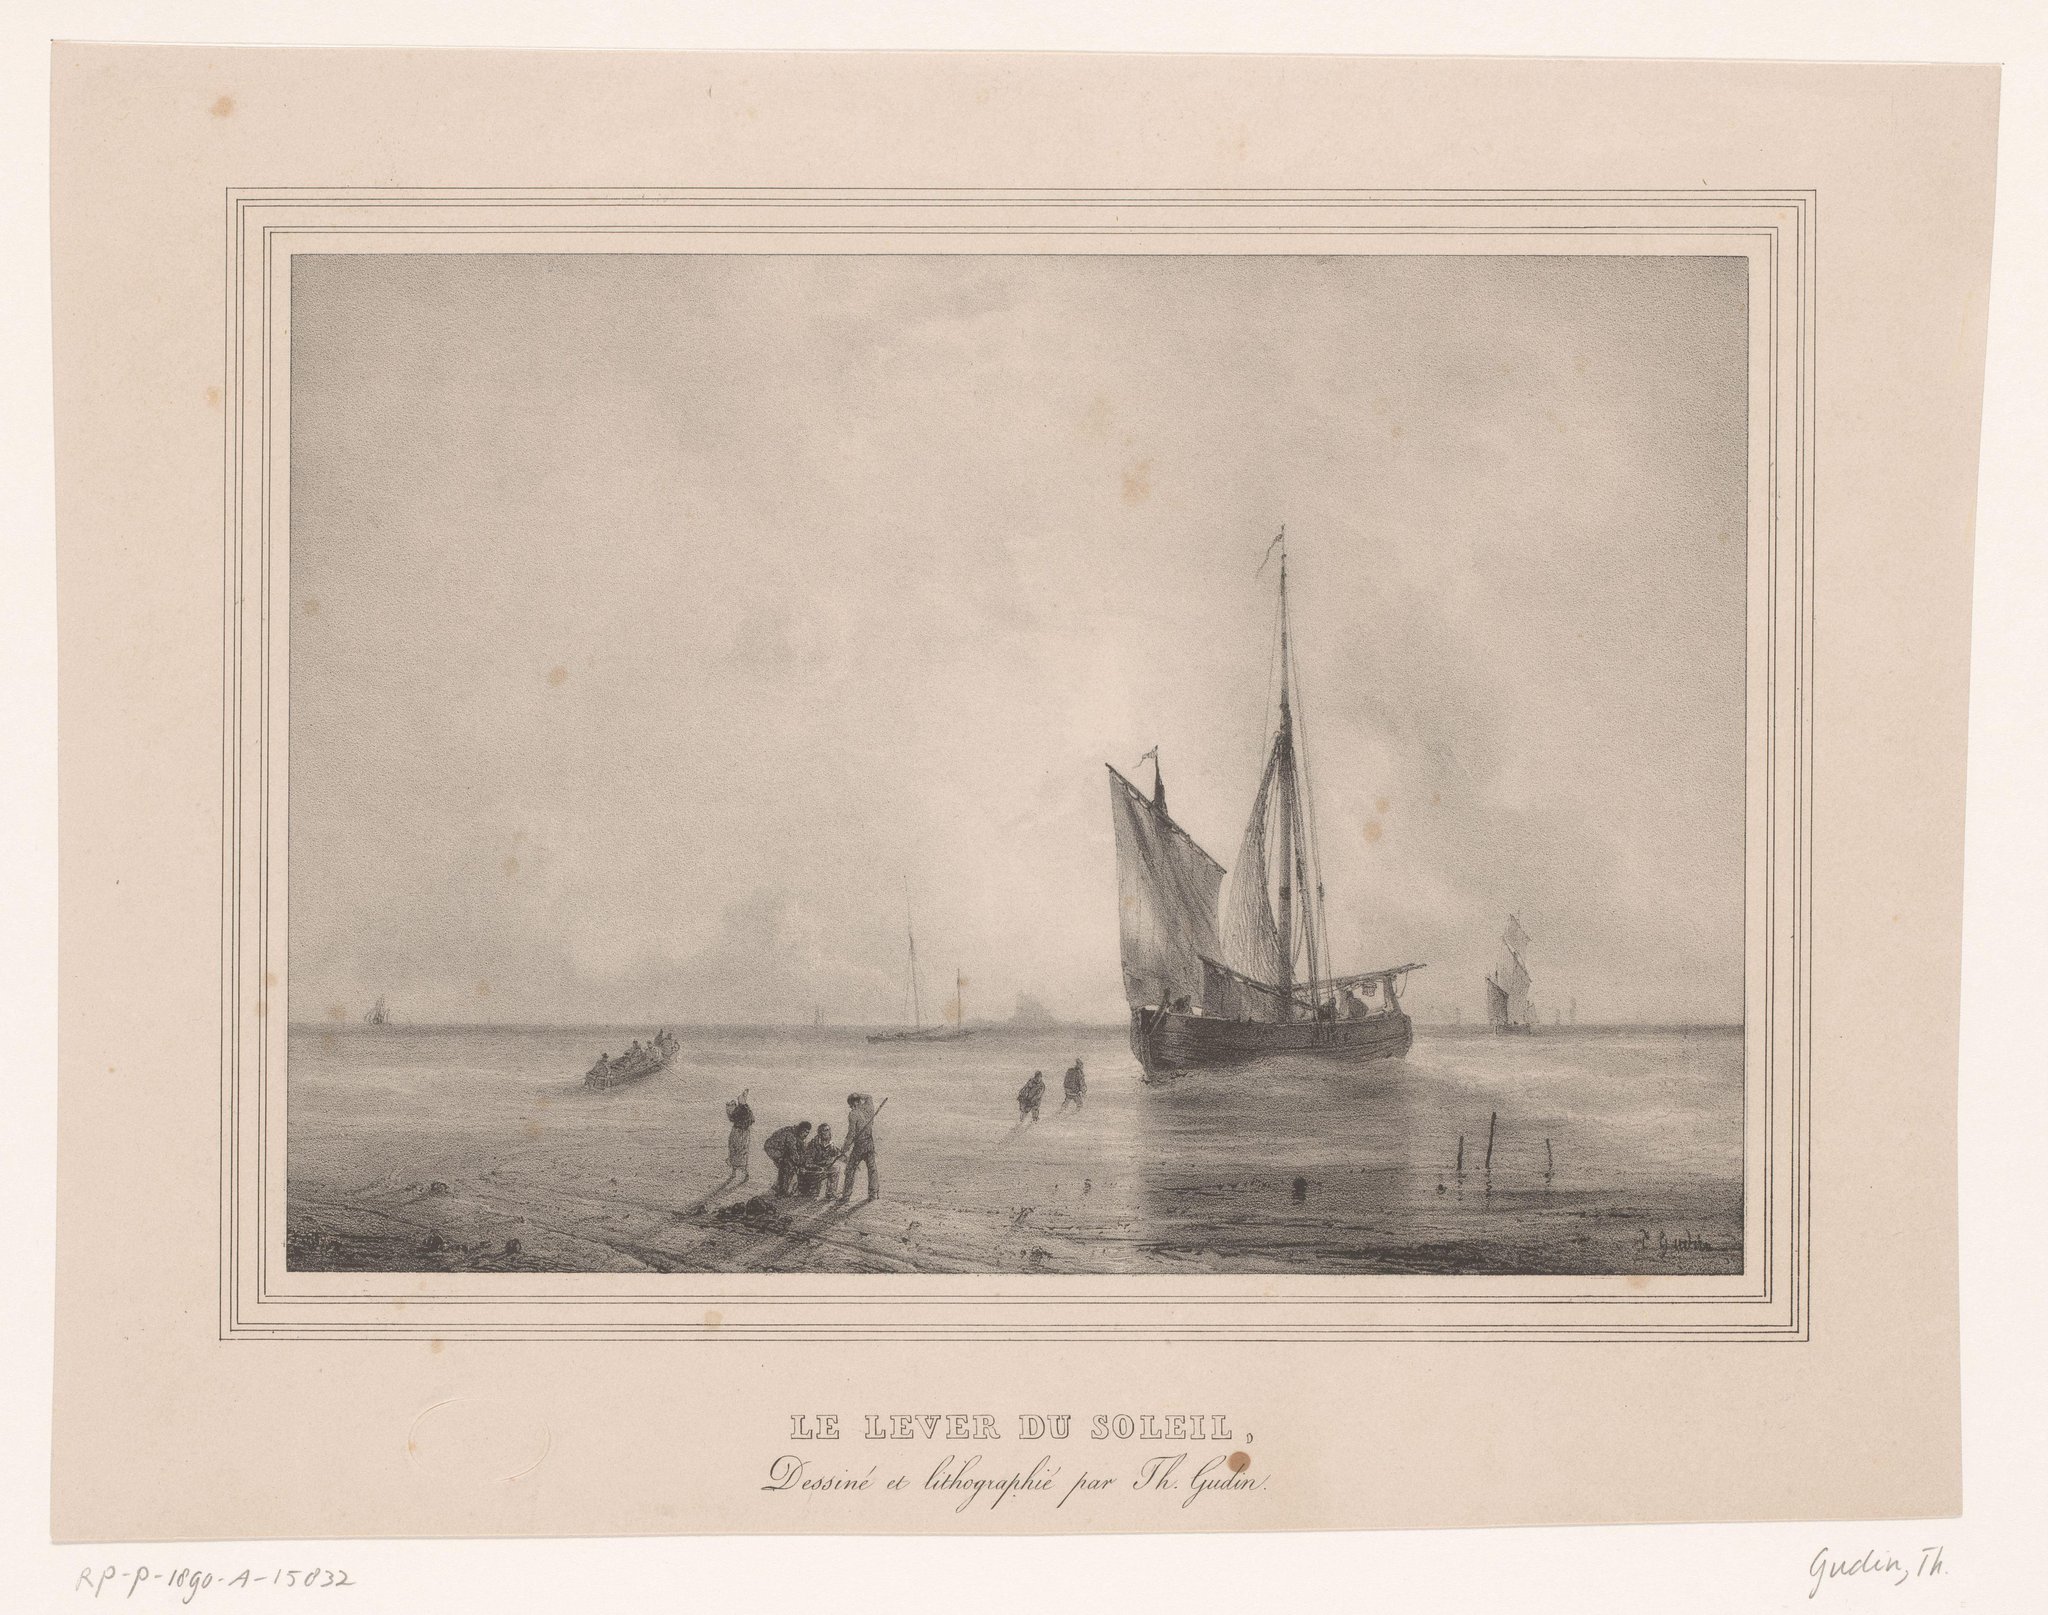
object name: print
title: Schip voor anker bij zonsopgang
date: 1847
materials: paper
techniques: lithograph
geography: paris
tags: ships (in general), sunrise, beach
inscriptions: collector's mark: Lugt 2228a, check stamp: Lugt 1397c